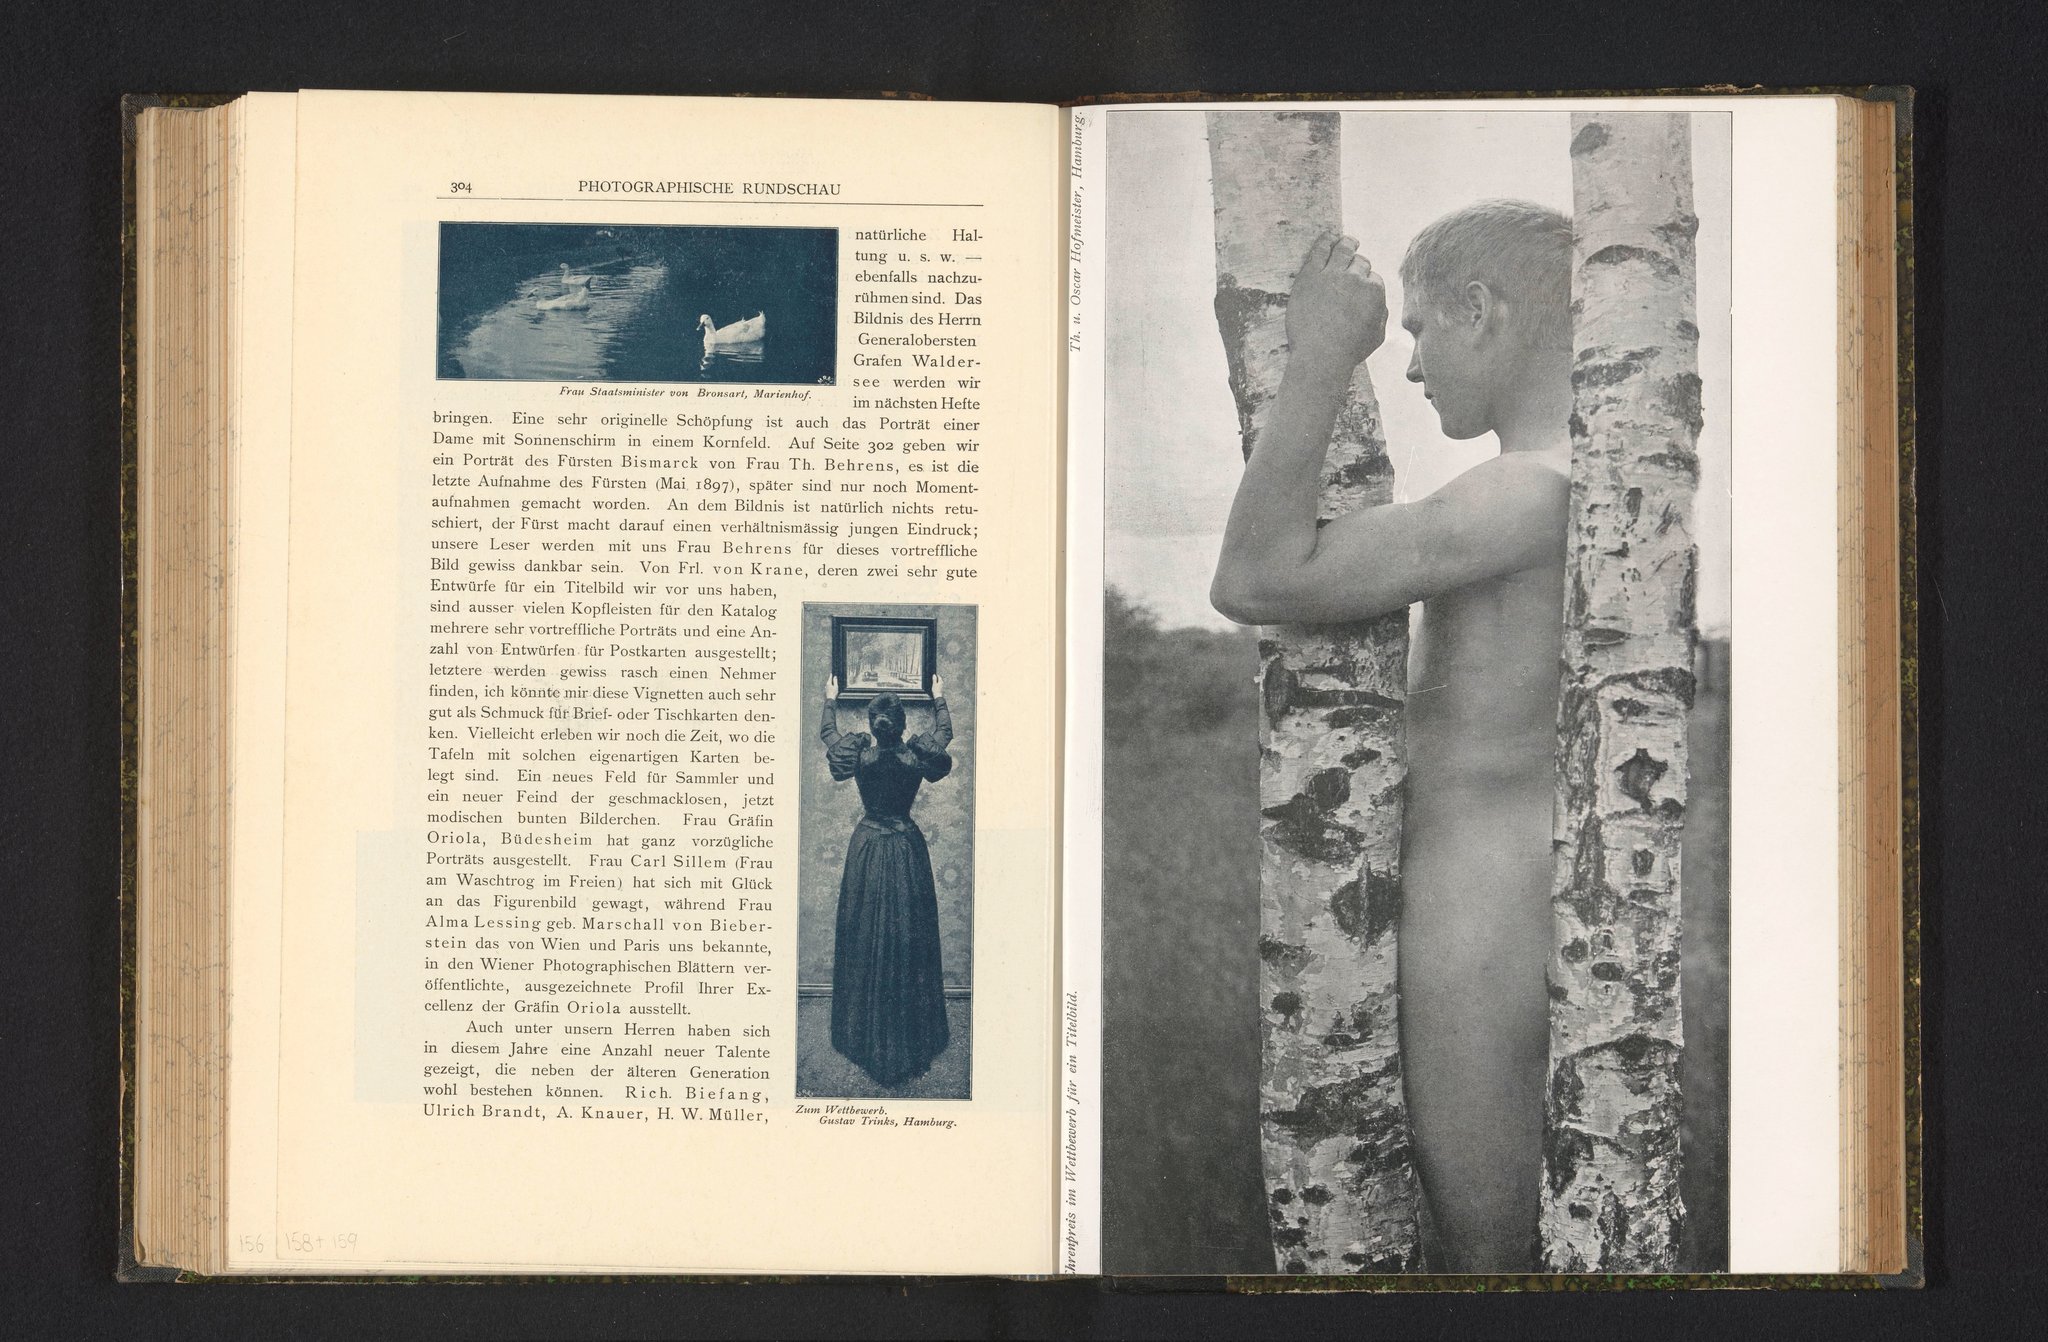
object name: page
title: Ehrenpreis im wettbewerb für ein titelbild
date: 1893-1898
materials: paper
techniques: autotype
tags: trees, the (nude) human figure; 'corpo humano' (ripa), youth, adolescent